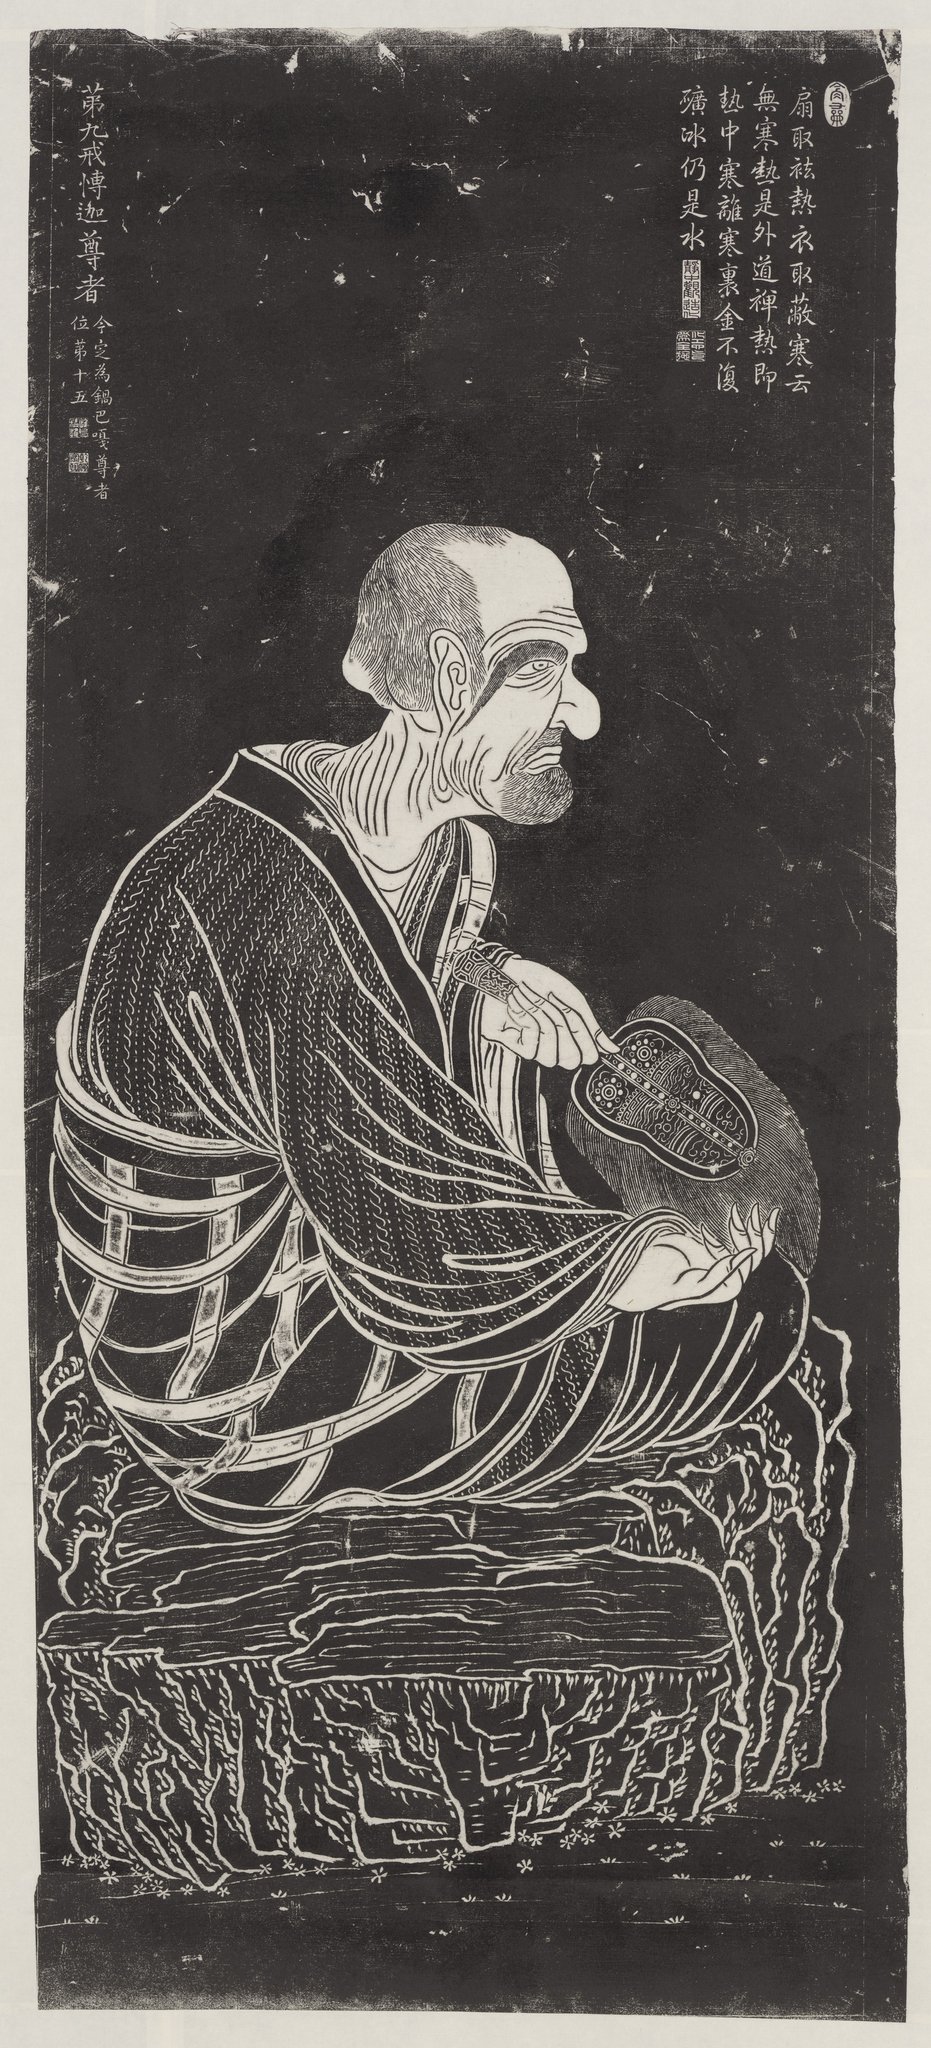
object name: rubbing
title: Luohan, after a set attributed to Guanxiu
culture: chinese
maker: unidentified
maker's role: artist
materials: ink, paper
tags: men